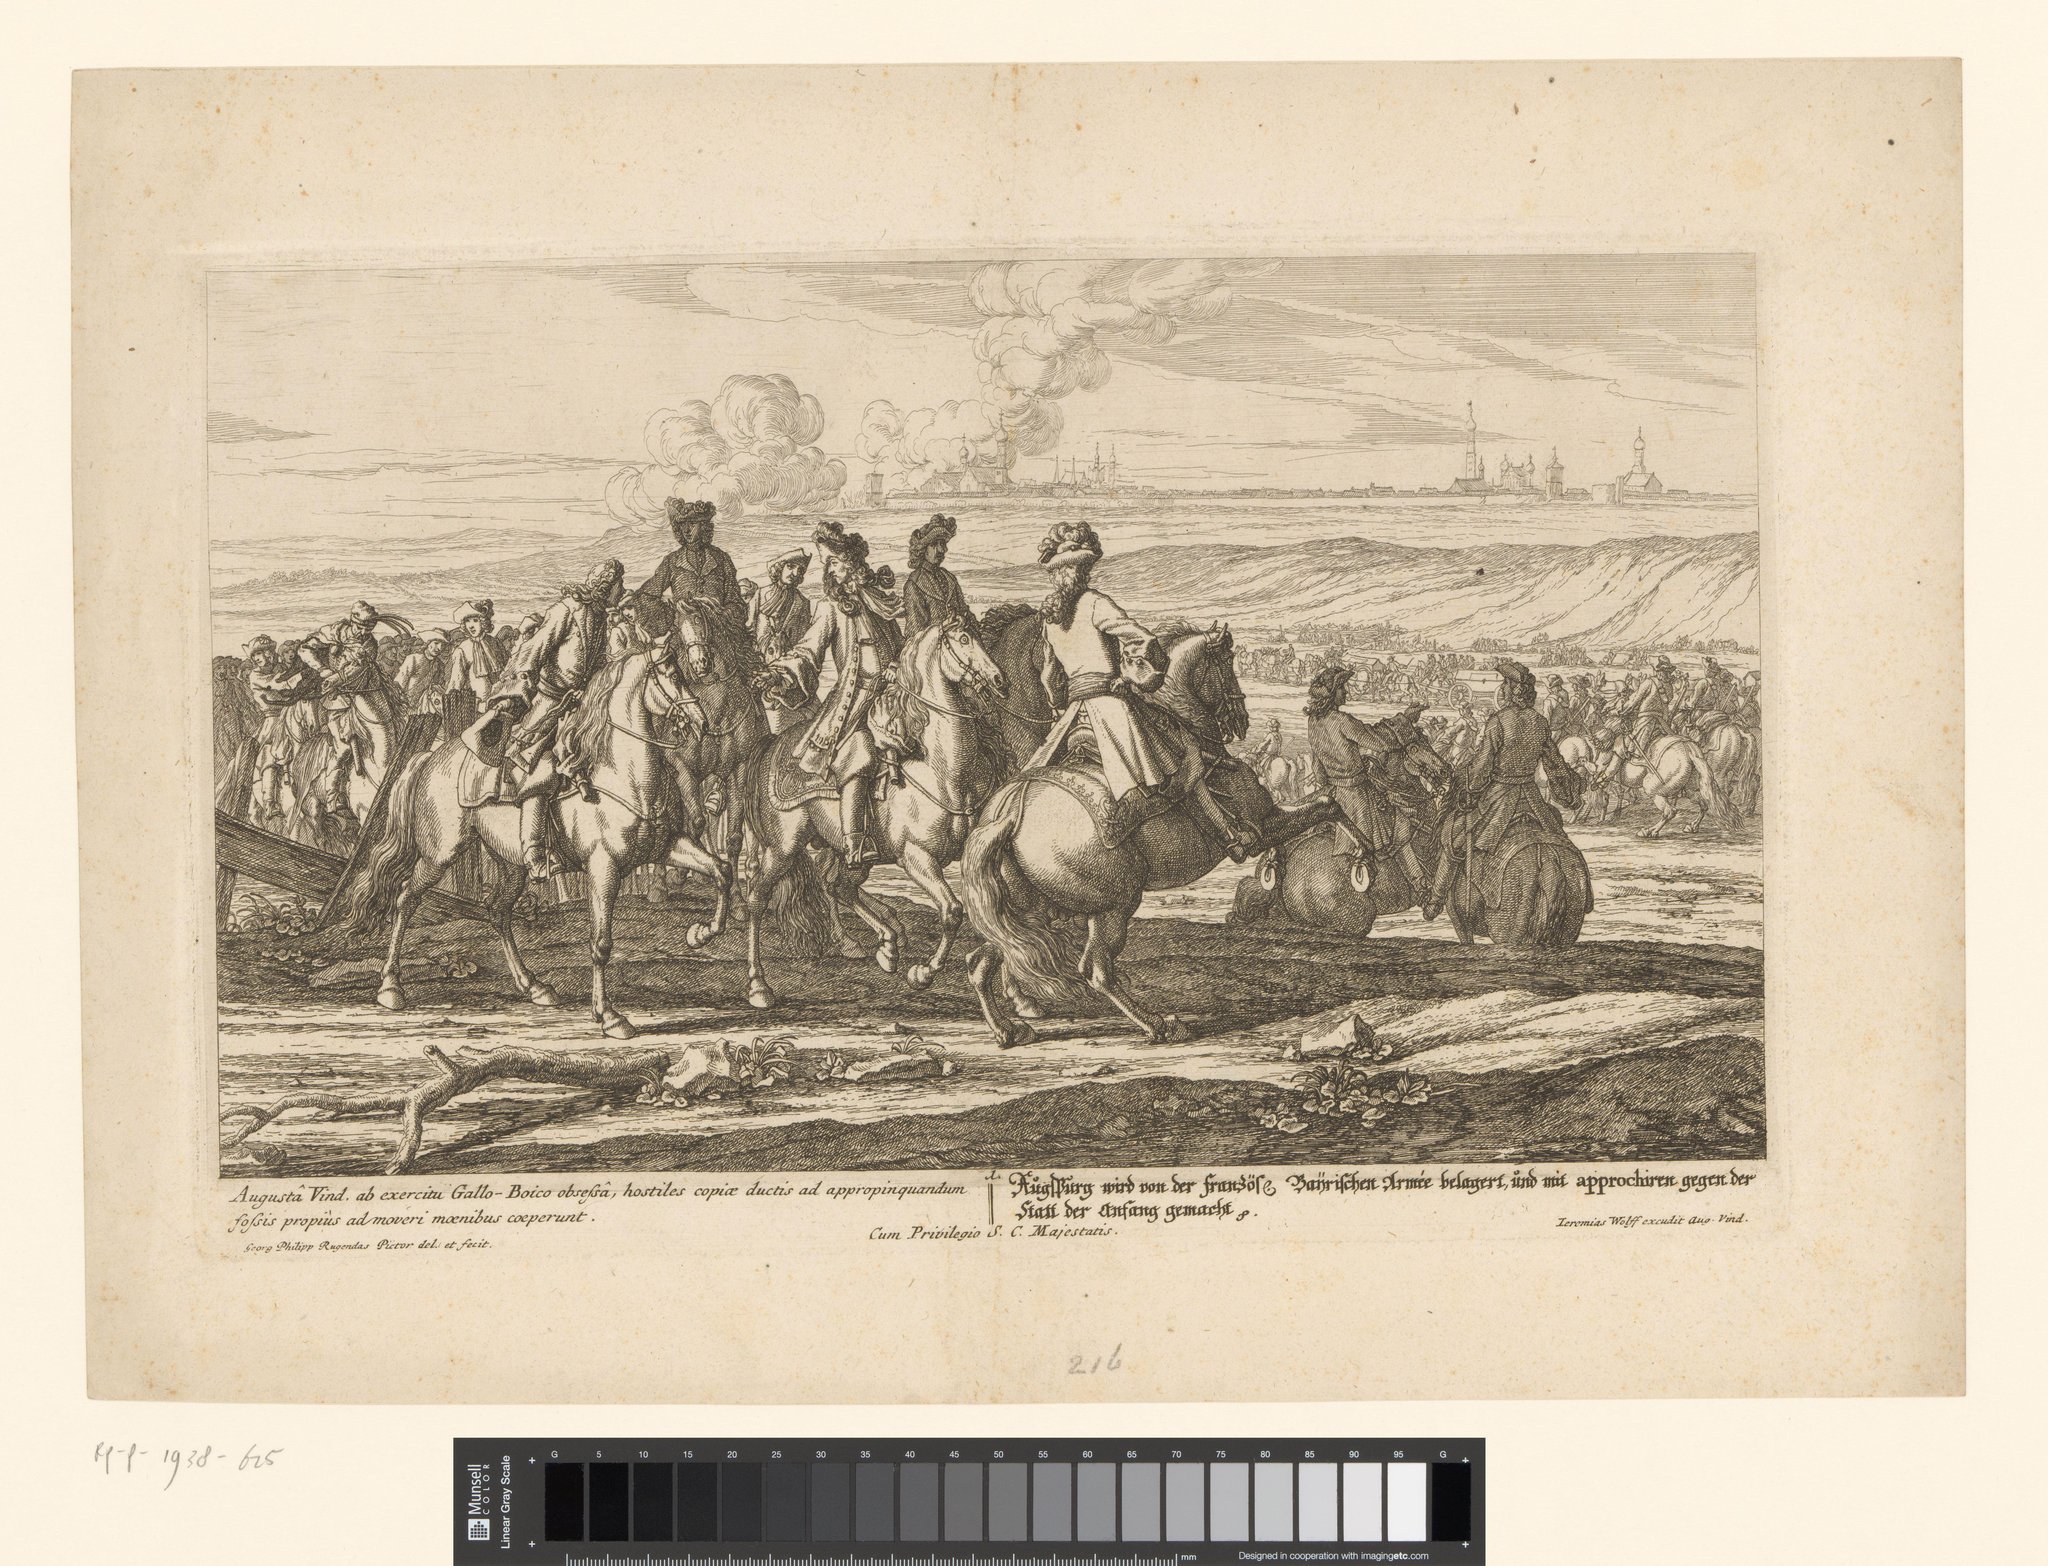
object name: print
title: Composities van het beleg van Augsburg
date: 1705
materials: paper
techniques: etching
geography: augsburg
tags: siege, augsburg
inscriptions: number: ‘240’